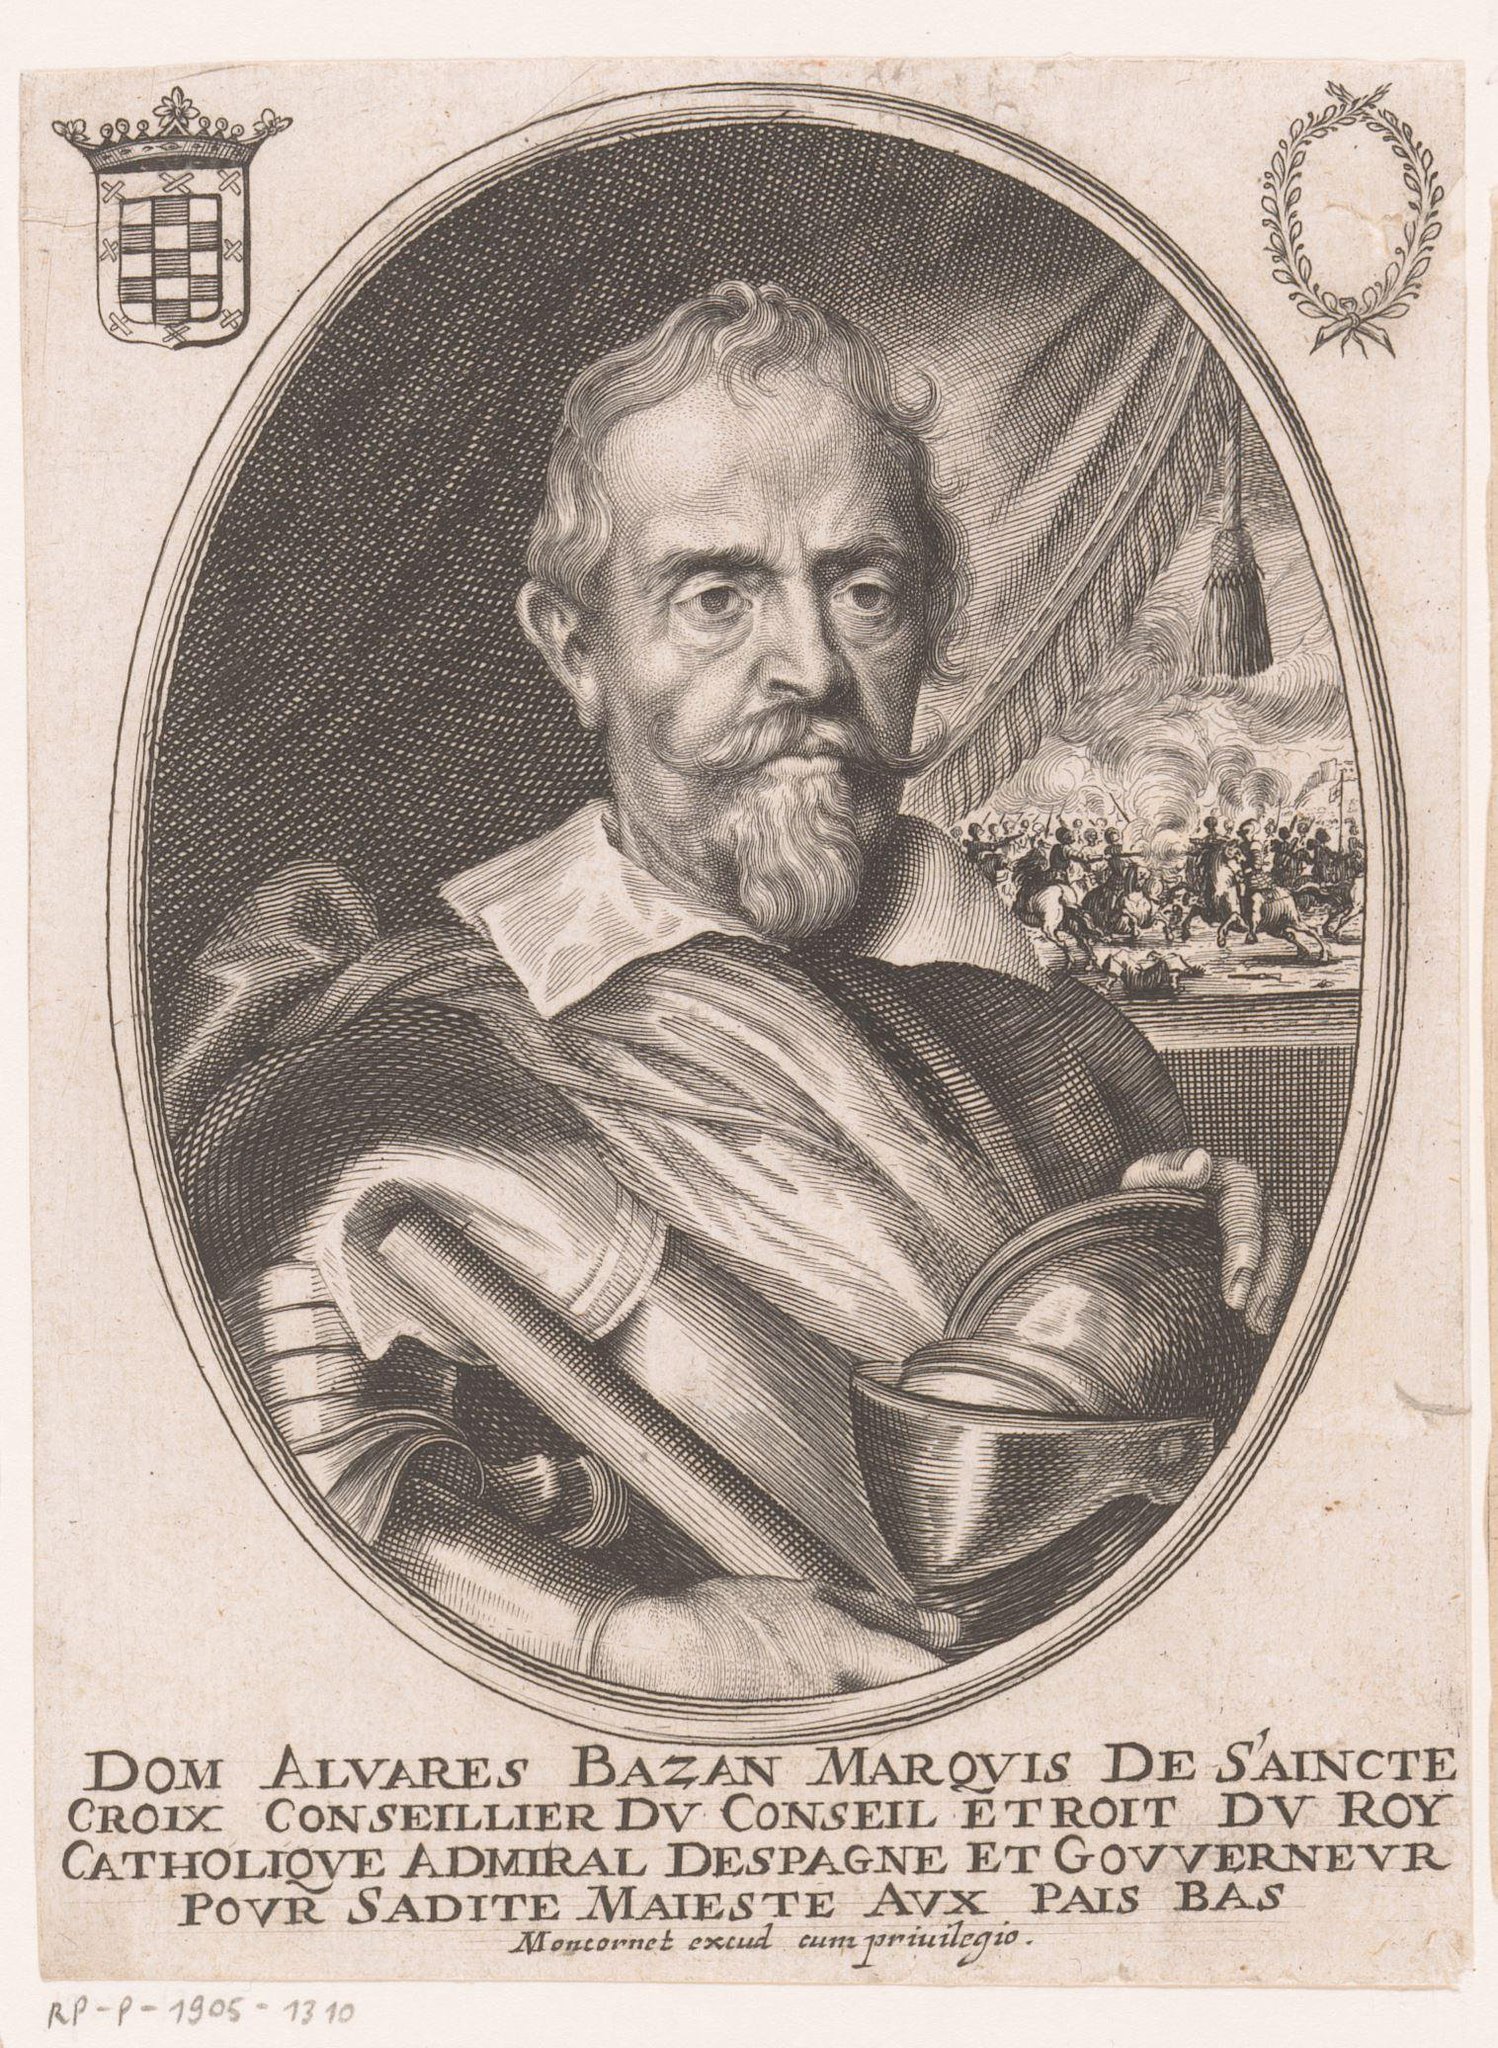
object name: print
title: Portret van Álvaro de Bazán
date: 1610-1668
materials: paper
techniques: engraving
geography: france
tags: álvaro de bazán, historical persons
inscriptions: collector's mark: Lugt 2228